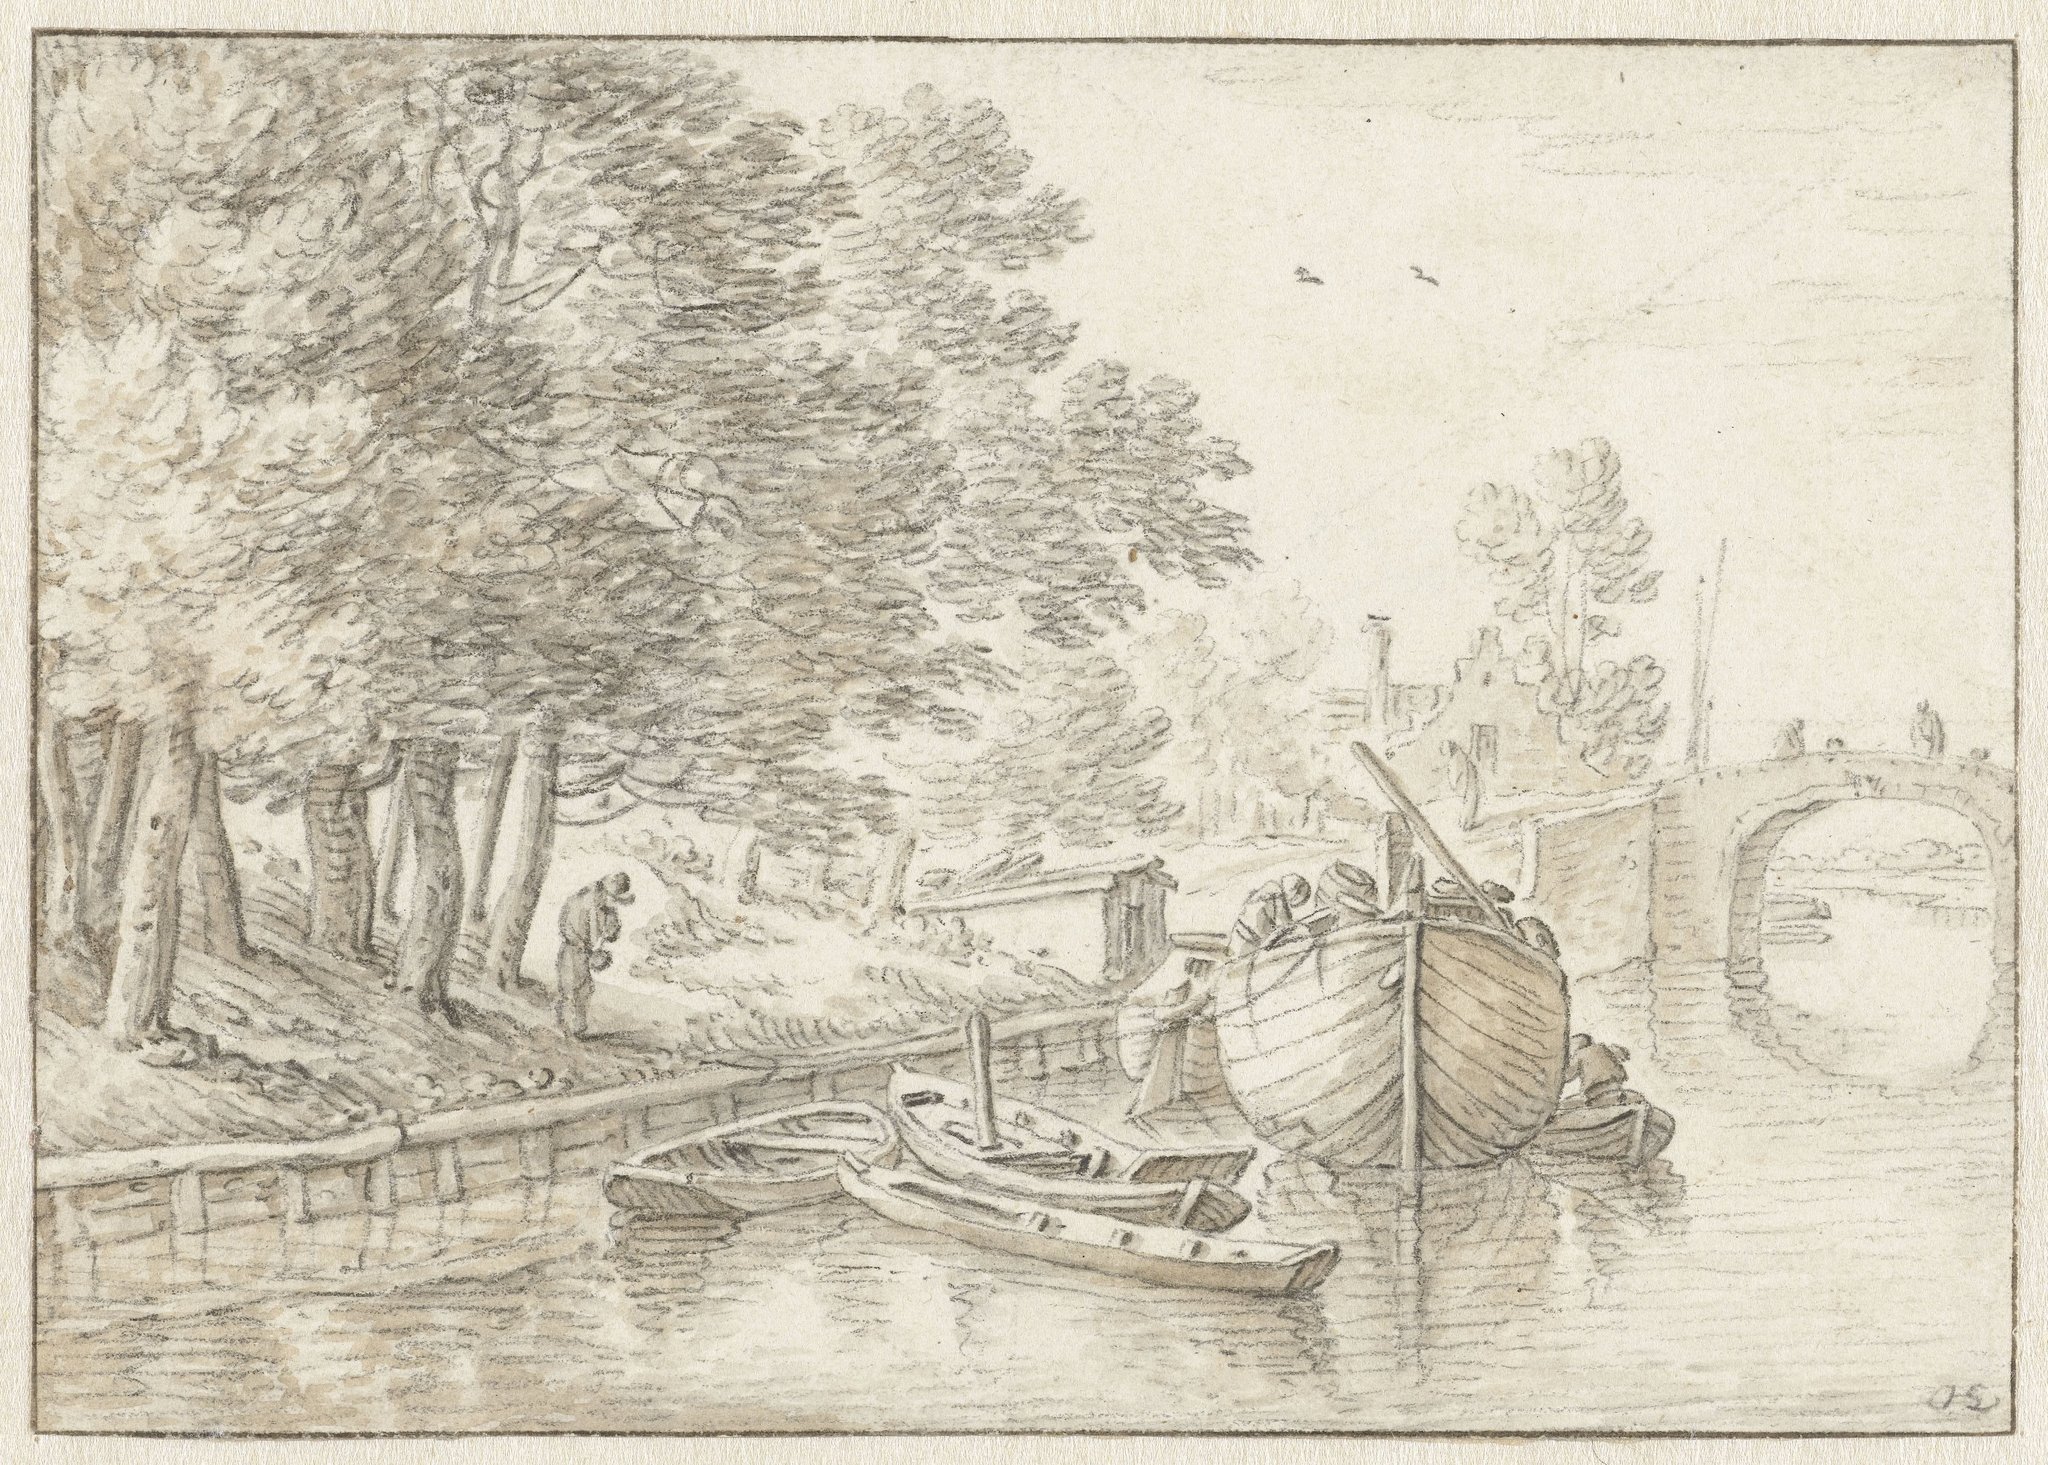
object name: drawing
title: Kanaaloever te Utrecht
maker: herman saftleven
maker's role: draughtsman, painter, print maker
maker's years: 1609-1685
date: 1619-1685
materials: chalk, paper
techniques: brush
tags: canals, waters (in city), utrecht